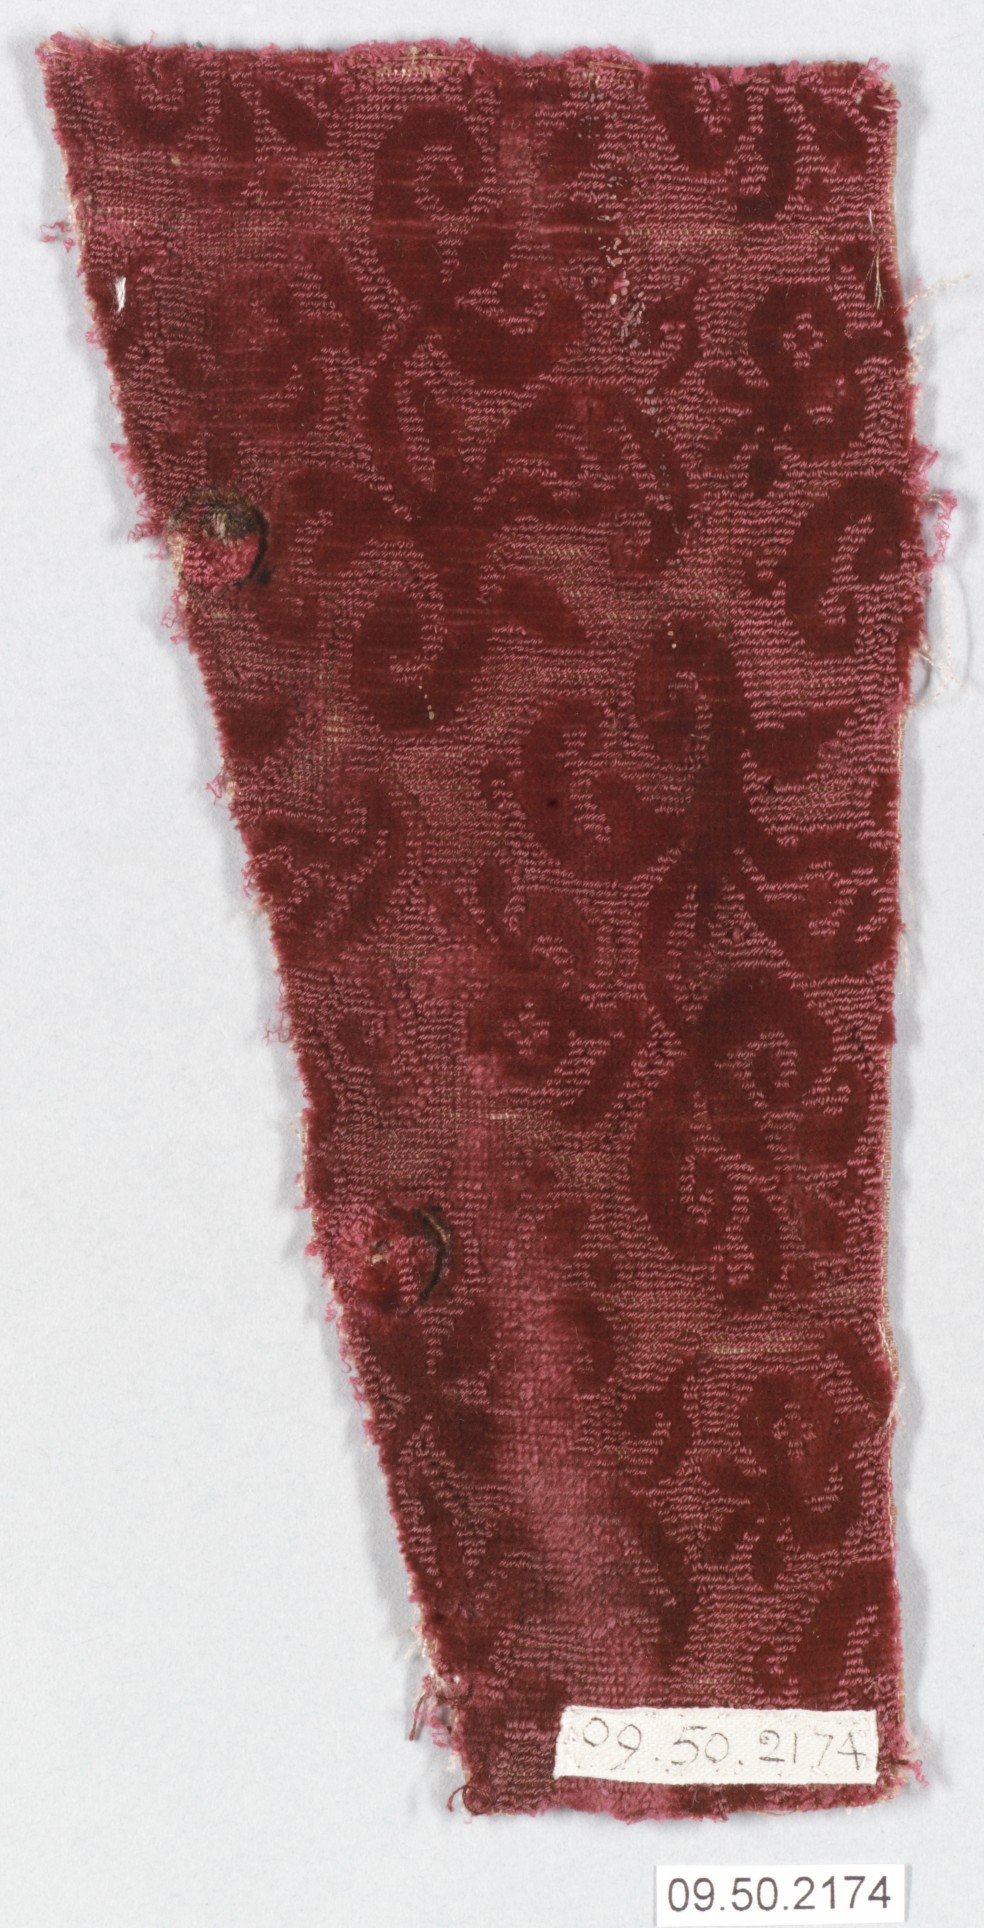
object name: piece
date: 1501-1700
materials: silk